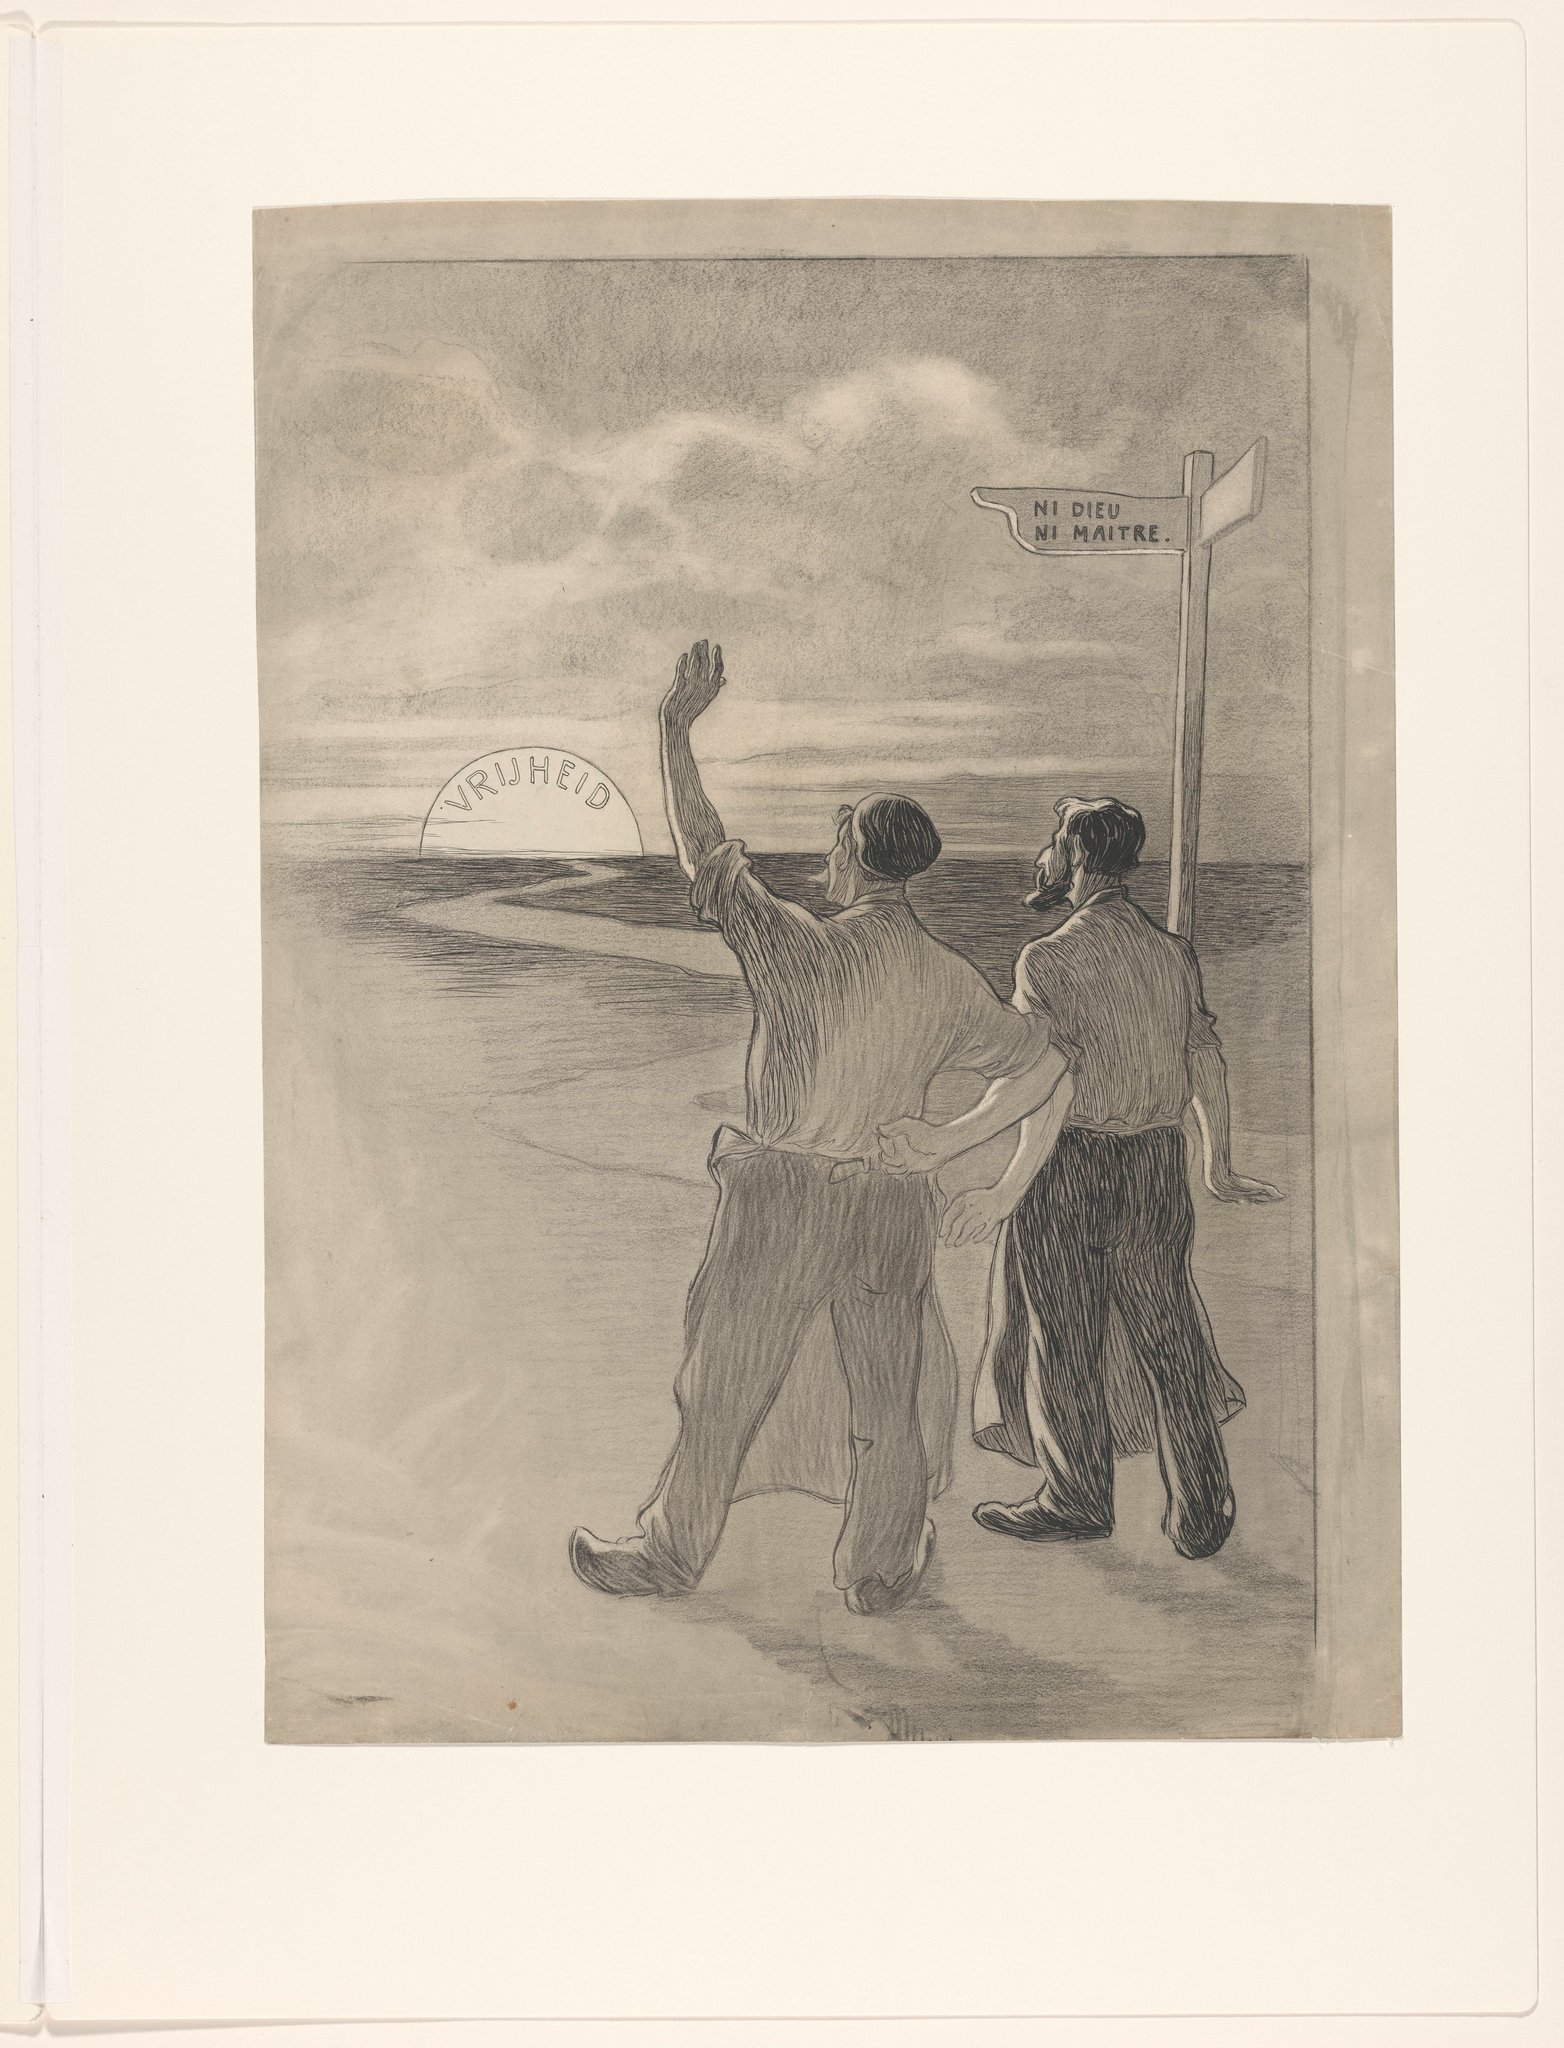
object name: drawing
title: Vrijheid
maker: jan de waardt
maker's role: draughtsman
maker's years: 1871-1909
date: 1875-1900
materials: chalk, paper, pencil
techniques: brush, pen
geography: netherlands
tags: modern professional organization, trade union, working class, labourers, sunrise, netherlands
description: In een vlak landschap bewonderen twee arbeiders de opkomst van zon van de Vrijheid. Rechts achter hen staat een wegwijzer, links van hen een opgaande zon. Op de keerzijde een schets van arbeiders die de zon groeten die met het woord 'Vrijheid' opkomt boven industrielandschap.